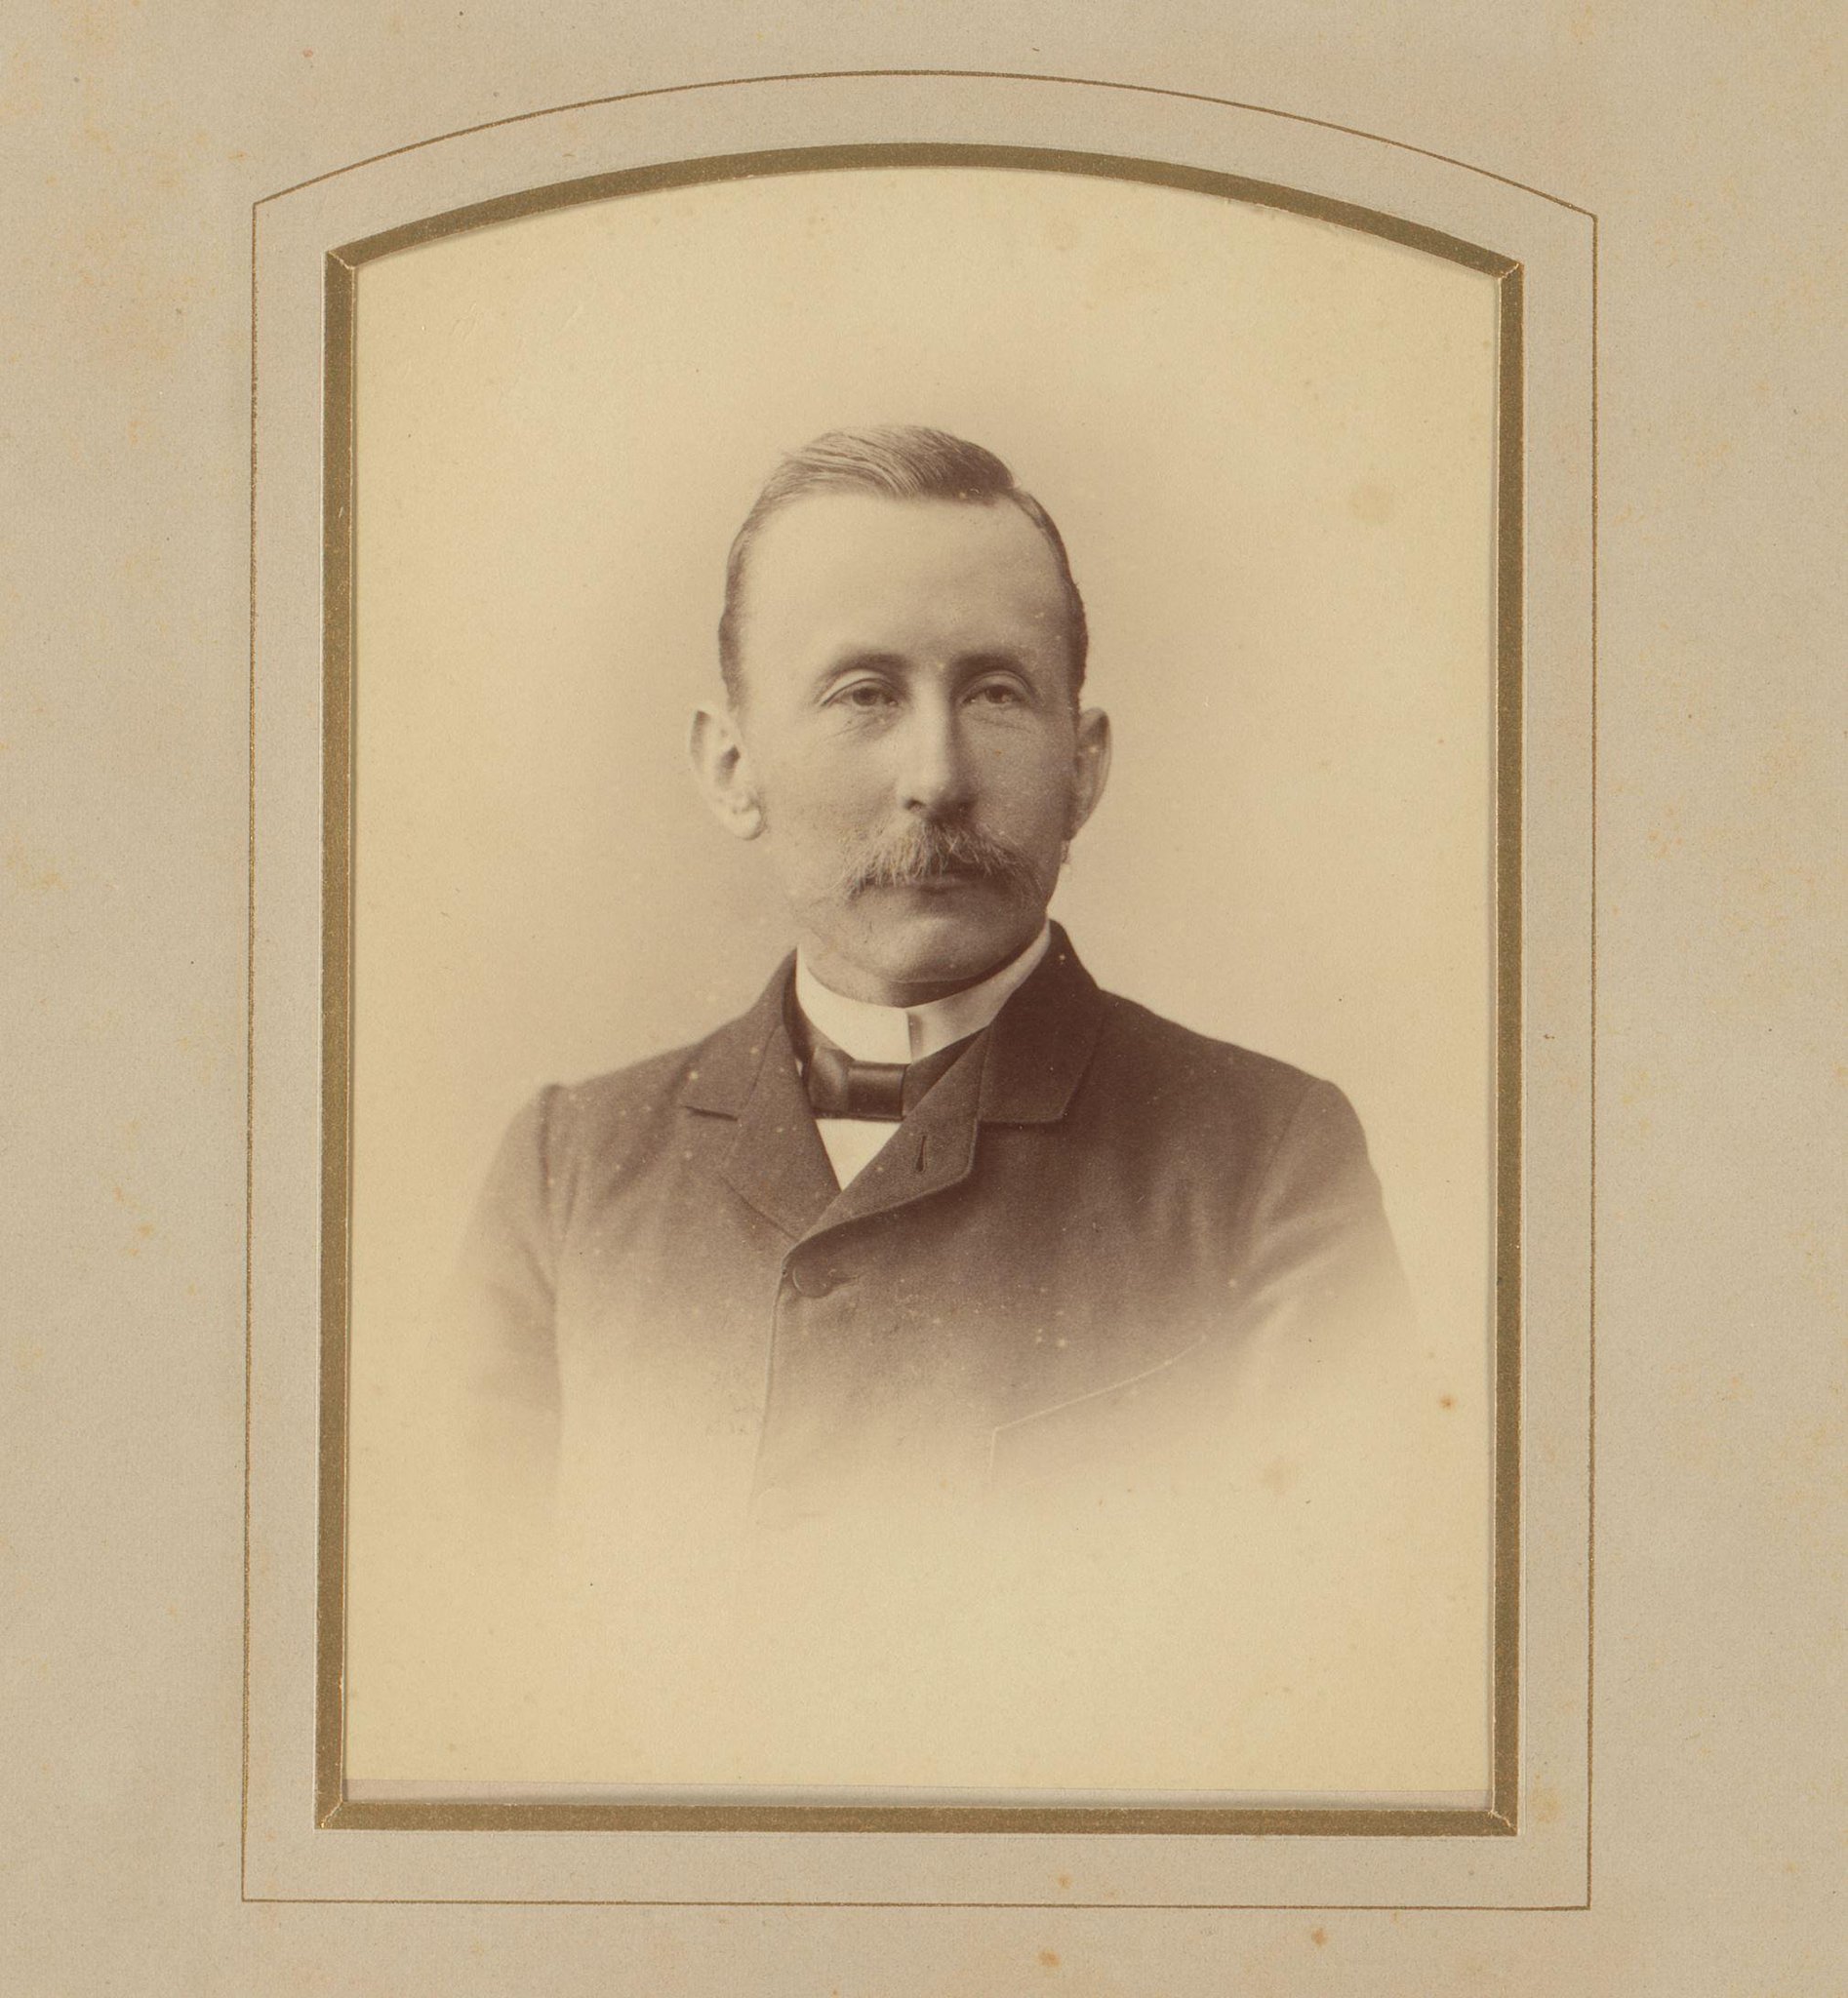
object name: photograph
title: Portret van J.B. Aug Kessler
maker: kameke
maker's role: painter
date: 1880-1890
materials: paper, photographic support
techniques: photography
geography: the hague